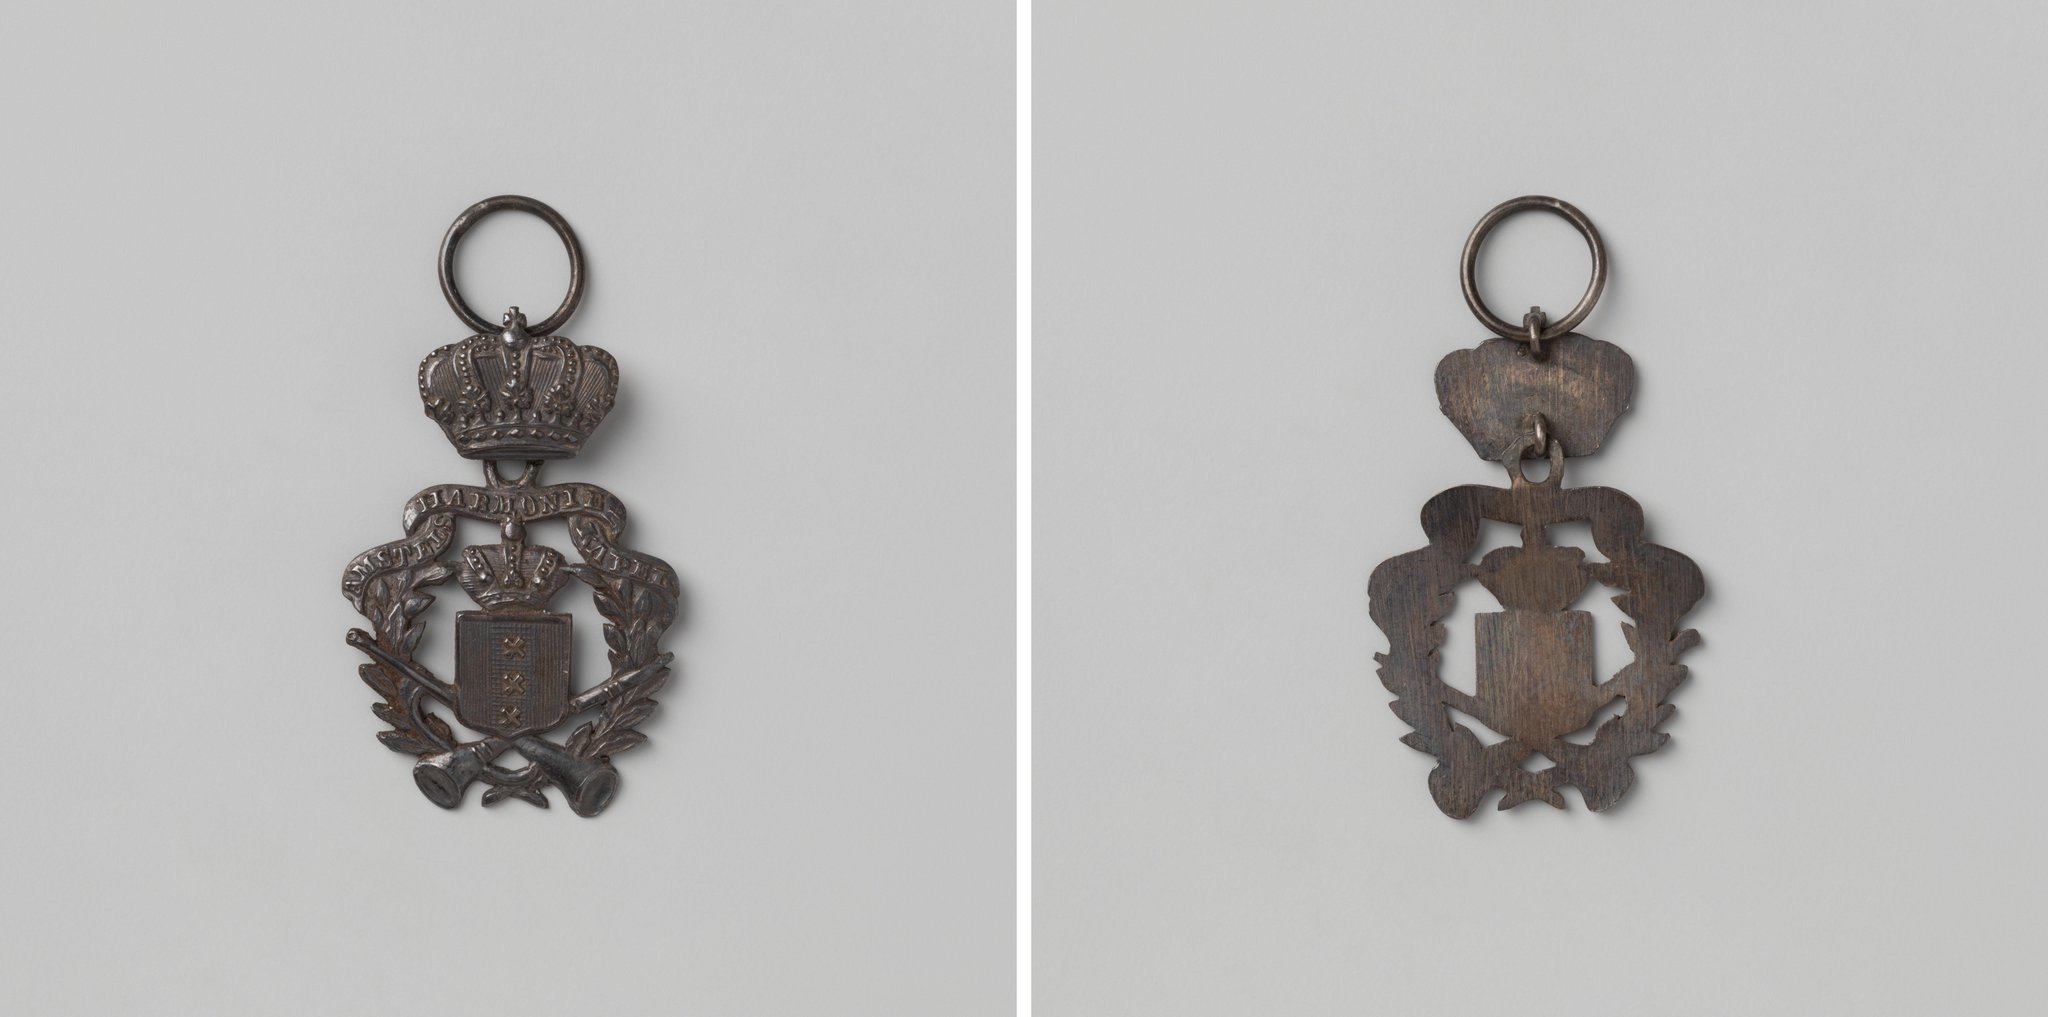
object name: insignia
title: Amstels Harmonie Kapel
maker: Anonymous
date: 1825-1875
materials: silver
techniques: striking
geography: amsterdam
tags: amsterdam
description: eenzijdig draagteken in vorm van gekroond wapenschild op twee gekruiste blaasinstrumenten binnen lauwerkrans onder wimpel met opschrift; daaraan draagoog, waaraan kroon is bevestigd